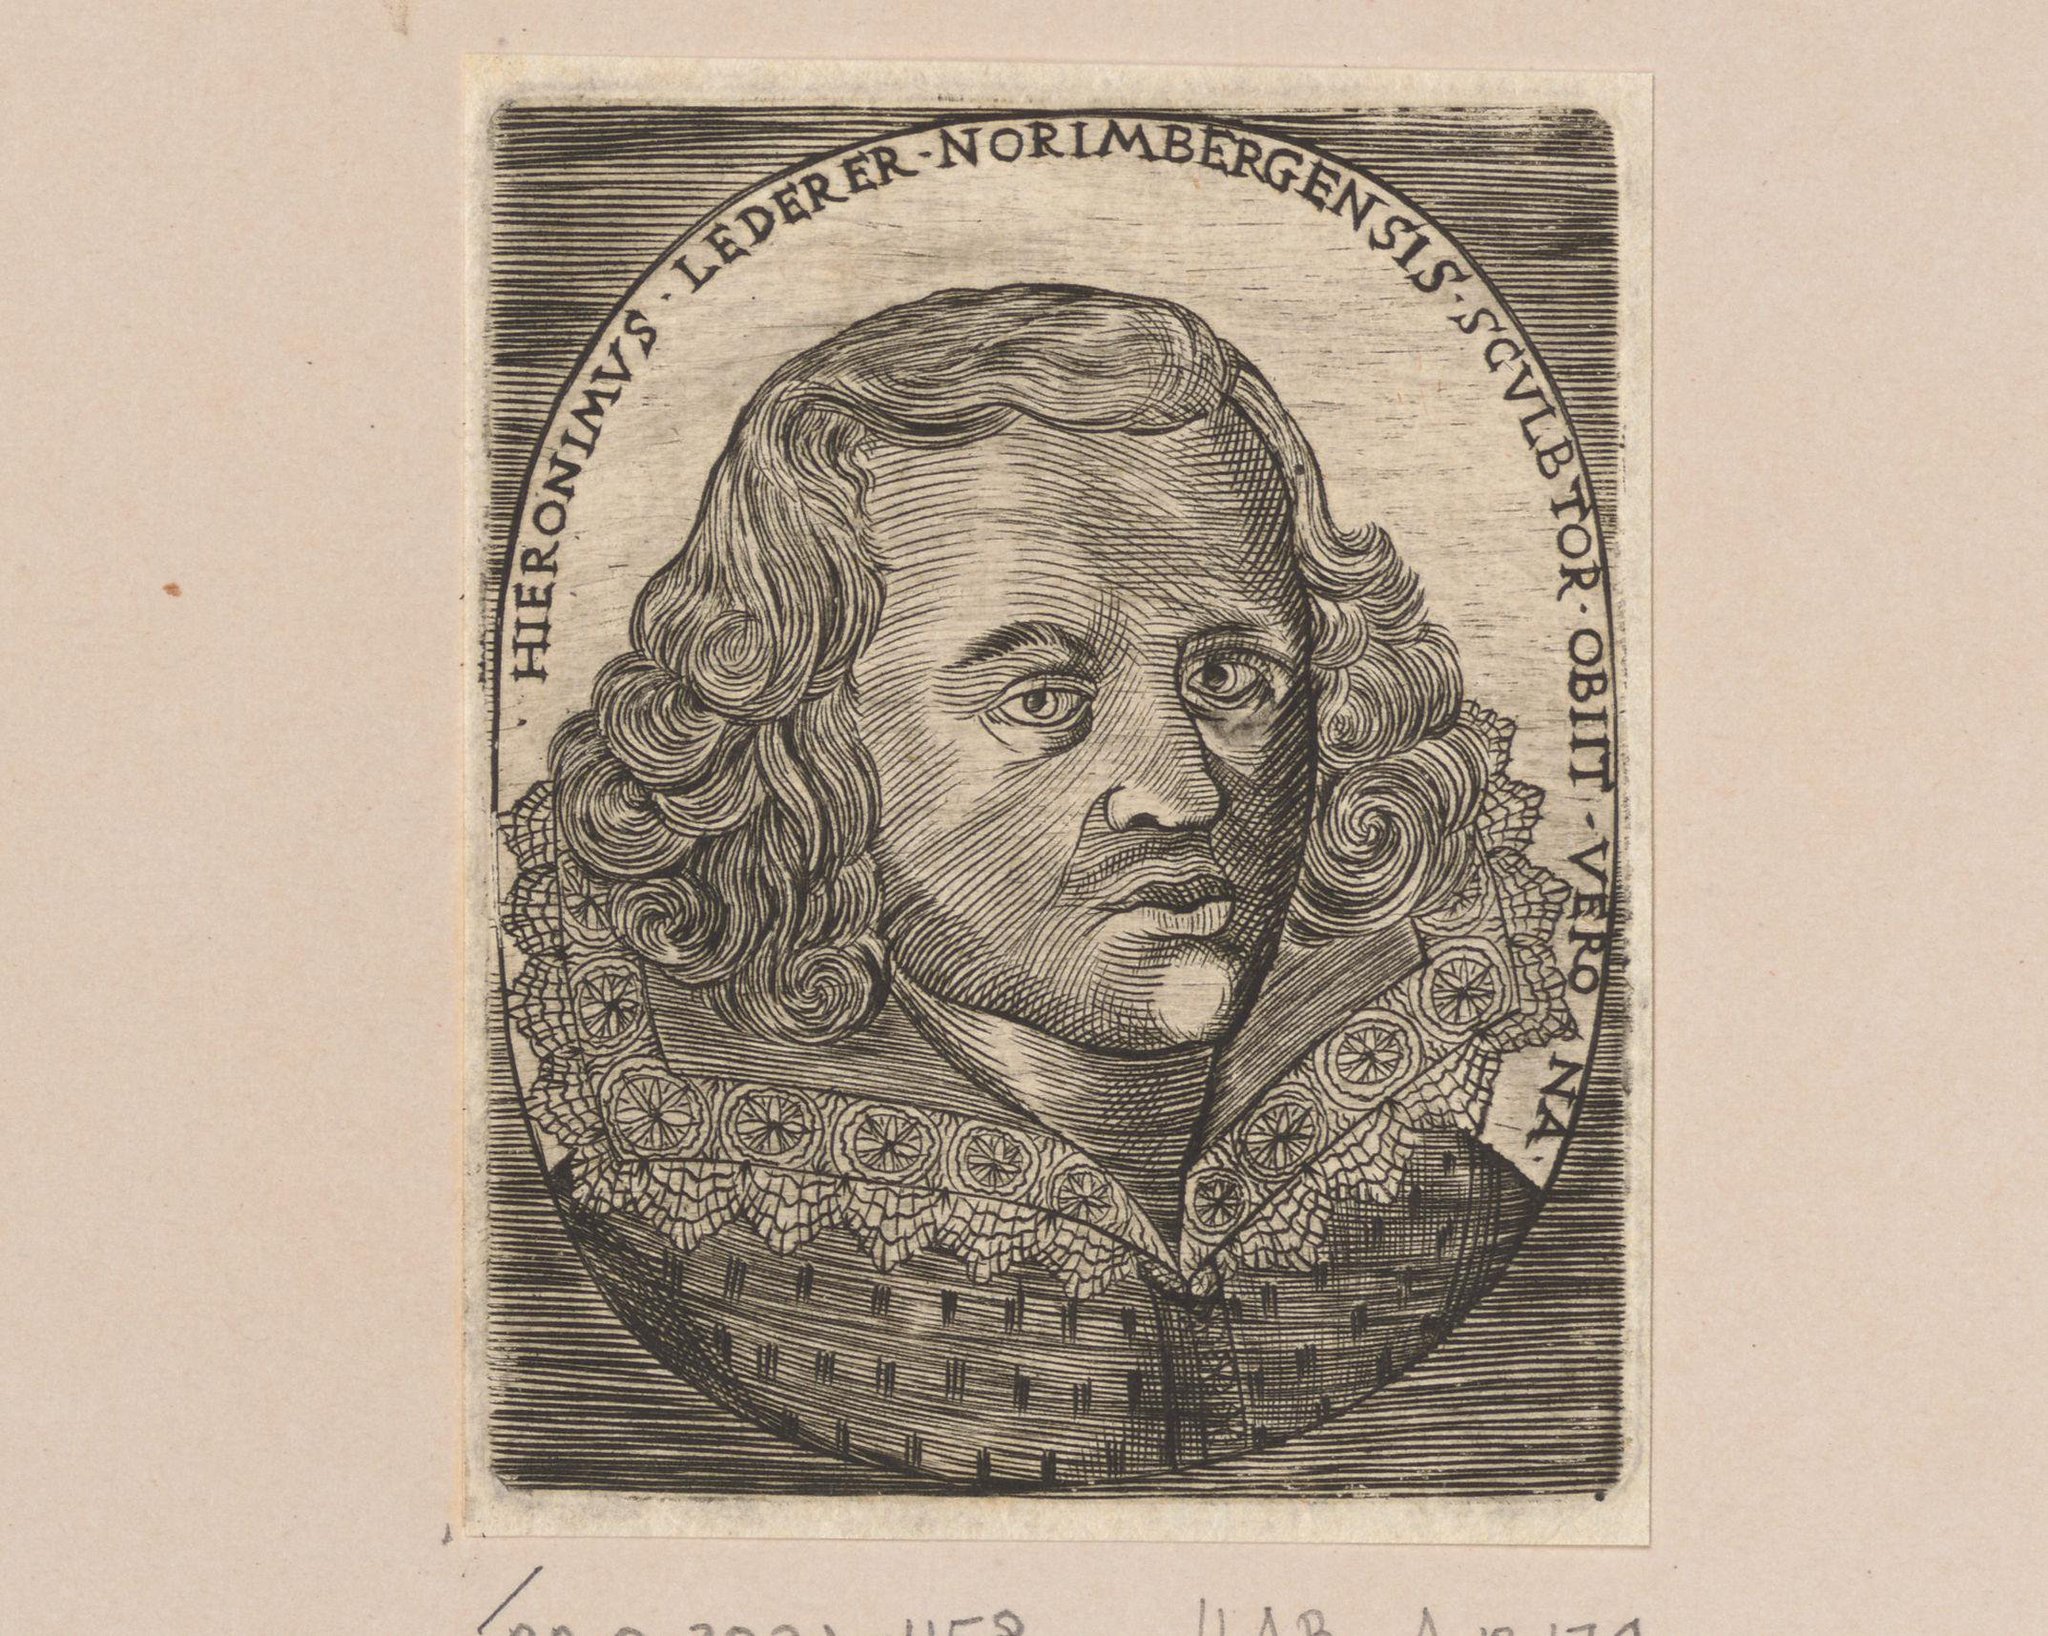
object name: print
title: Portret van Hieronymus Lederer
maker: Anonymous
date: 1615-1699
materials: paper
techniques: engraving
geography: germany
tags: print maker, hieronymus lederer, historical persons, portrait, self-portrait of graphic artist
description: Met tekst in het Latijn rondom het portret.